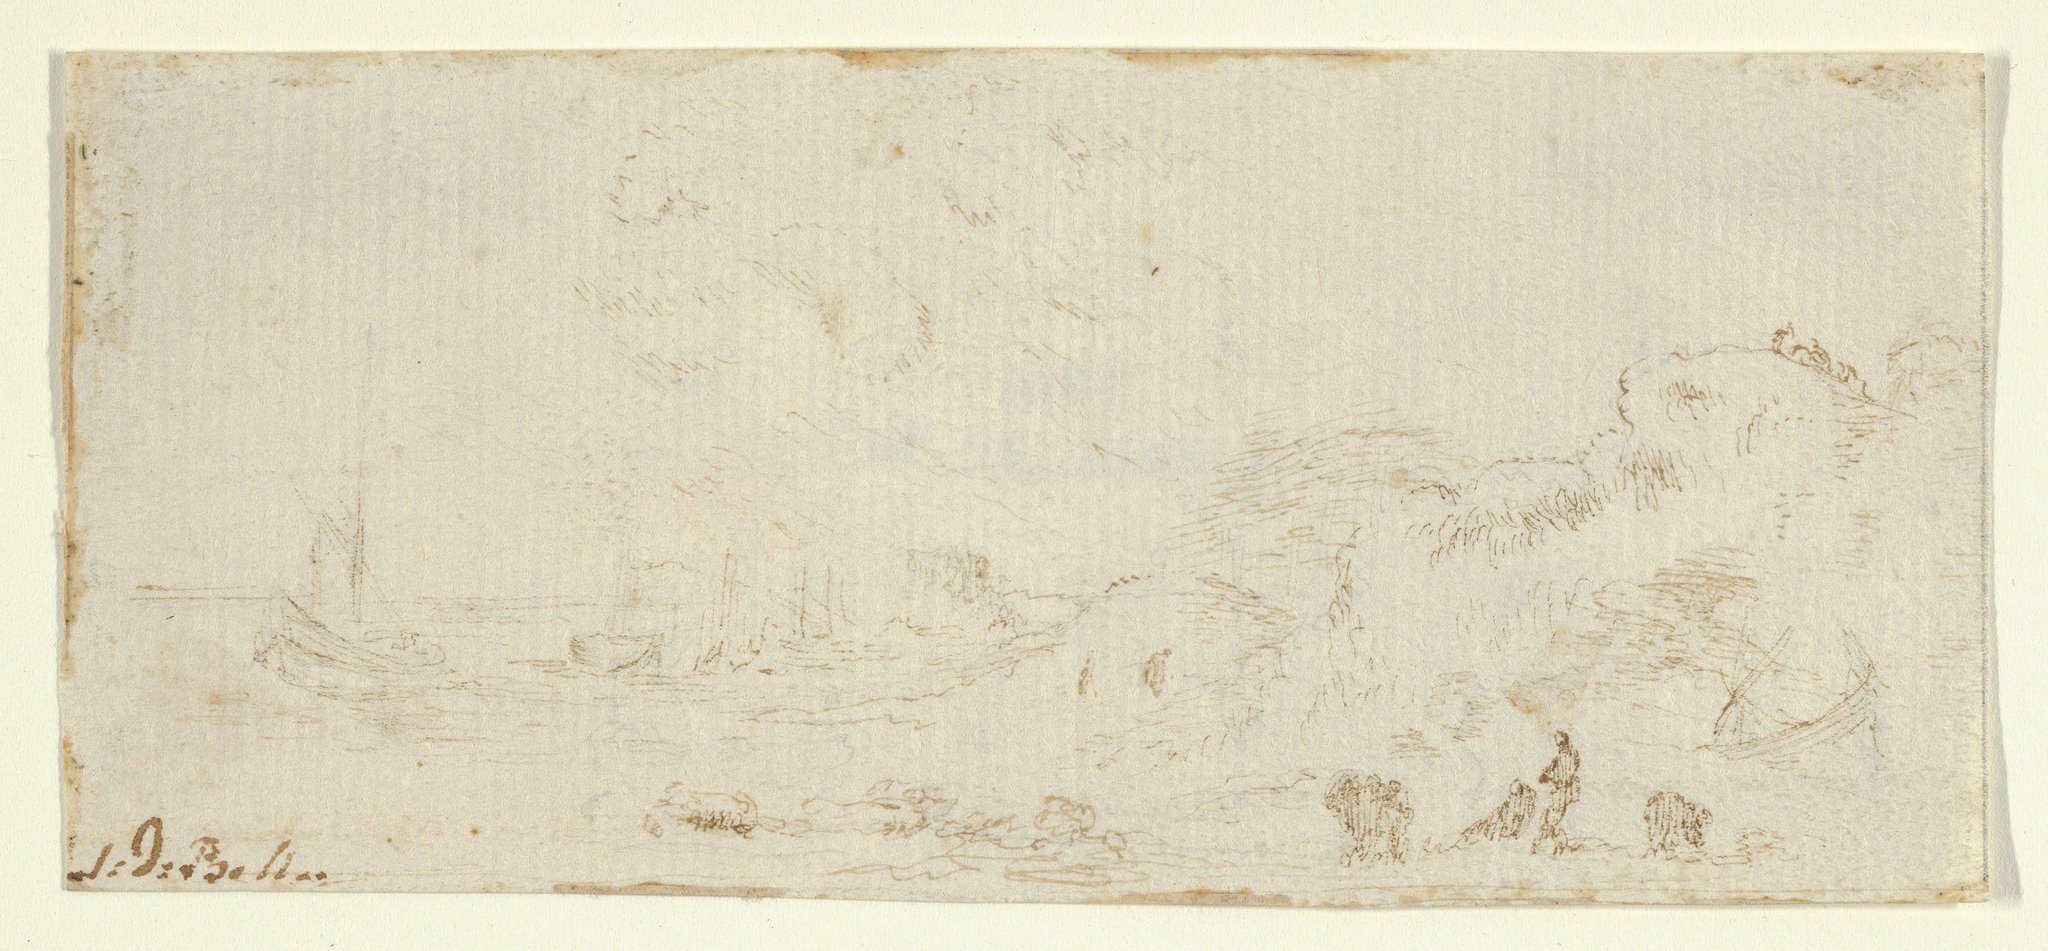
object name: drawing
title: Landscape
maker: stefano della bella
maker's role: artist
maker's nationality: italian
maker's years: 1610-1664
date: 1601-1700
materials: ink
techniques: pen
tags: landscapes